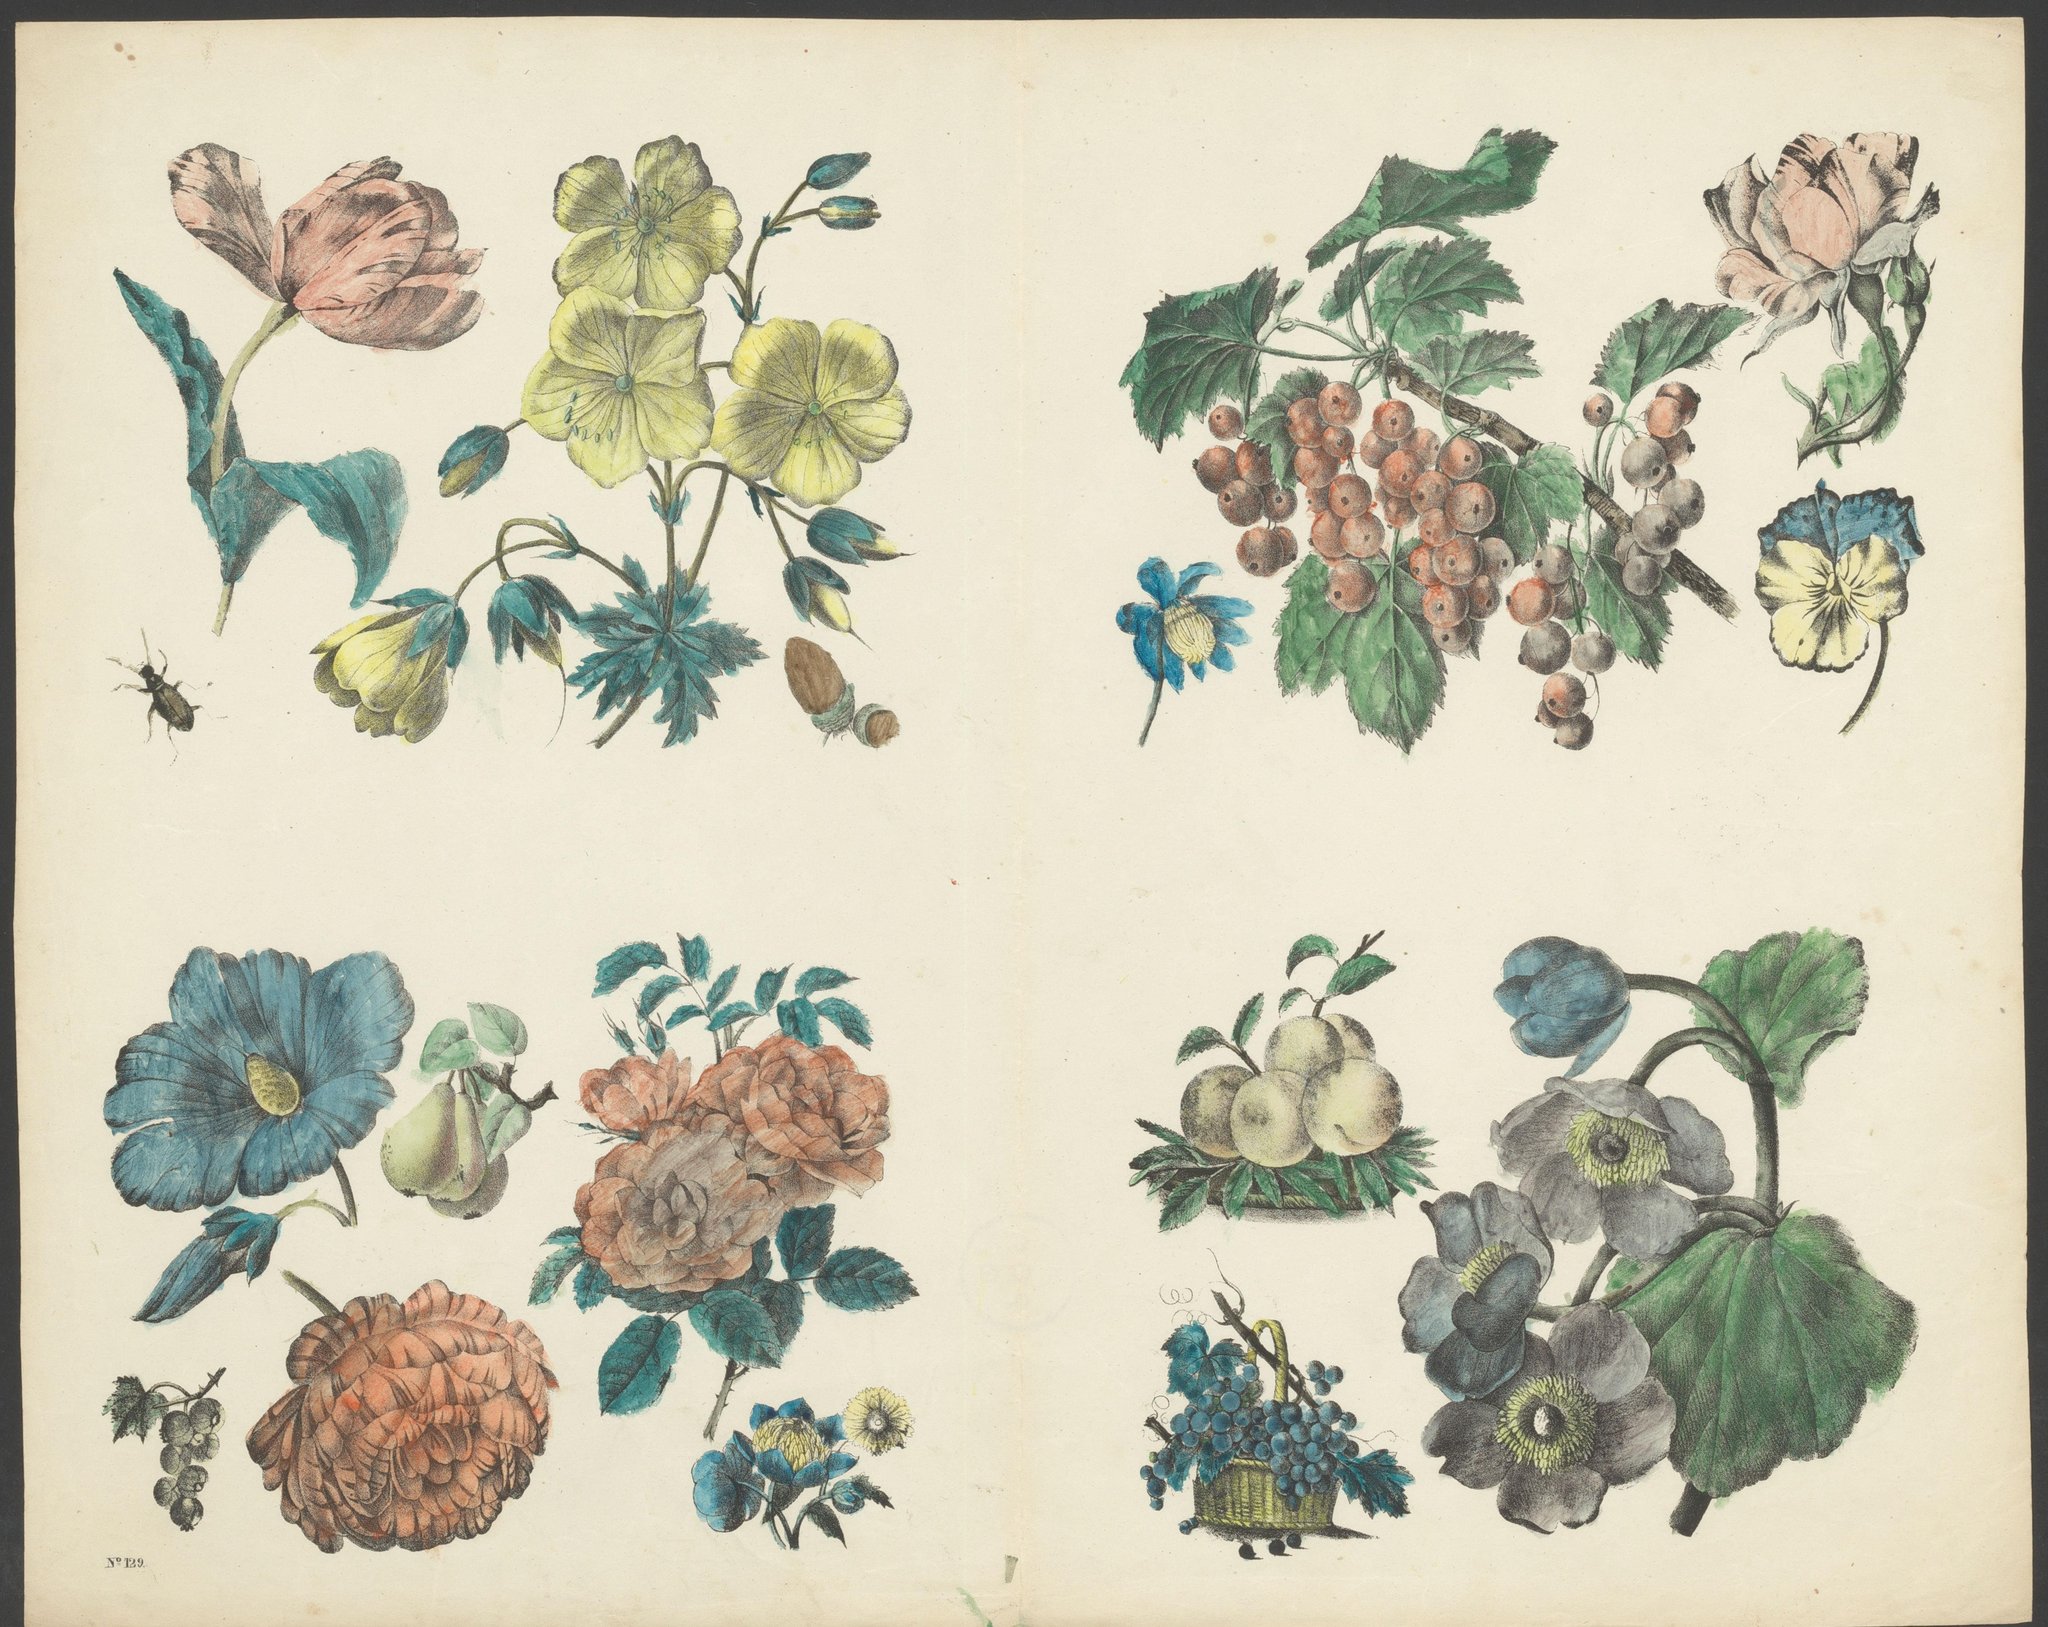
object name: popular print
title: Diverse bloemen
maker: Anonymous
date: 1800-1899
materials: paper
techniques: hand coloring, lithograph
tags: flowers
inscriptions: collector's mark: Lugt 1641, stamp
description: Linksonder genummerd: No. 129. Onderwerpsrubrieken binnen de Atlas Zeden en Gewoonten: Zeden en Gewoonten in Engeren Zin, Des menschen beging, midden en einde, Kinderleven – Kinderspel en Kinderprenten.